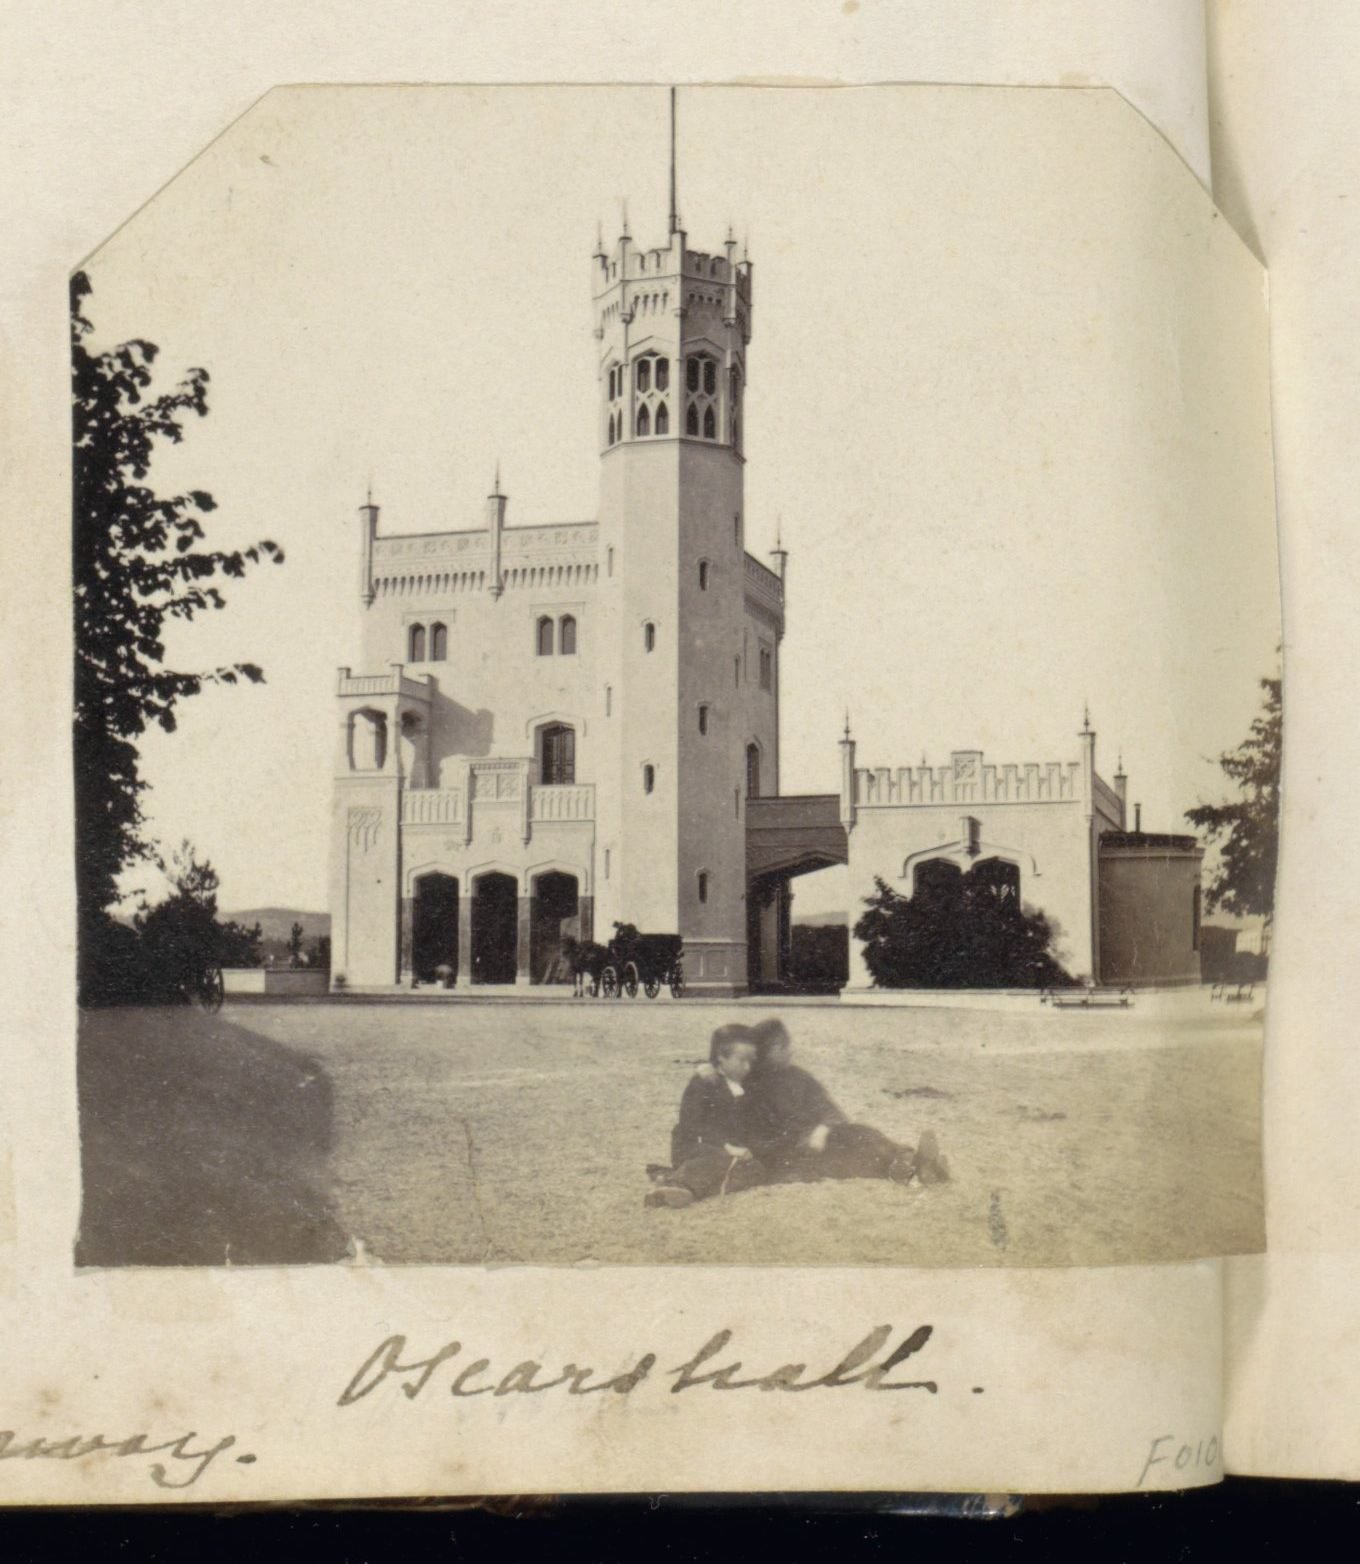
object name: photograph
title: Oscarhall. Norway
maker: Anonymous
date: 1860-1870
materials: paper, photographic support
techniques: albumen print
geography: oscarshall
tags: castle, lying on the back with uplifted upper part of the body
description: Onderdeel van Engels familiealbum met foto's van personen, reizen, cricket en kunstwerken.